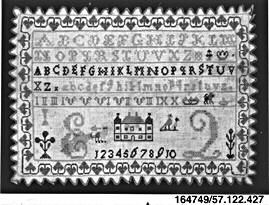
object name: sampler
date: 1801-1900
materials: linen, silk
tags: palaces